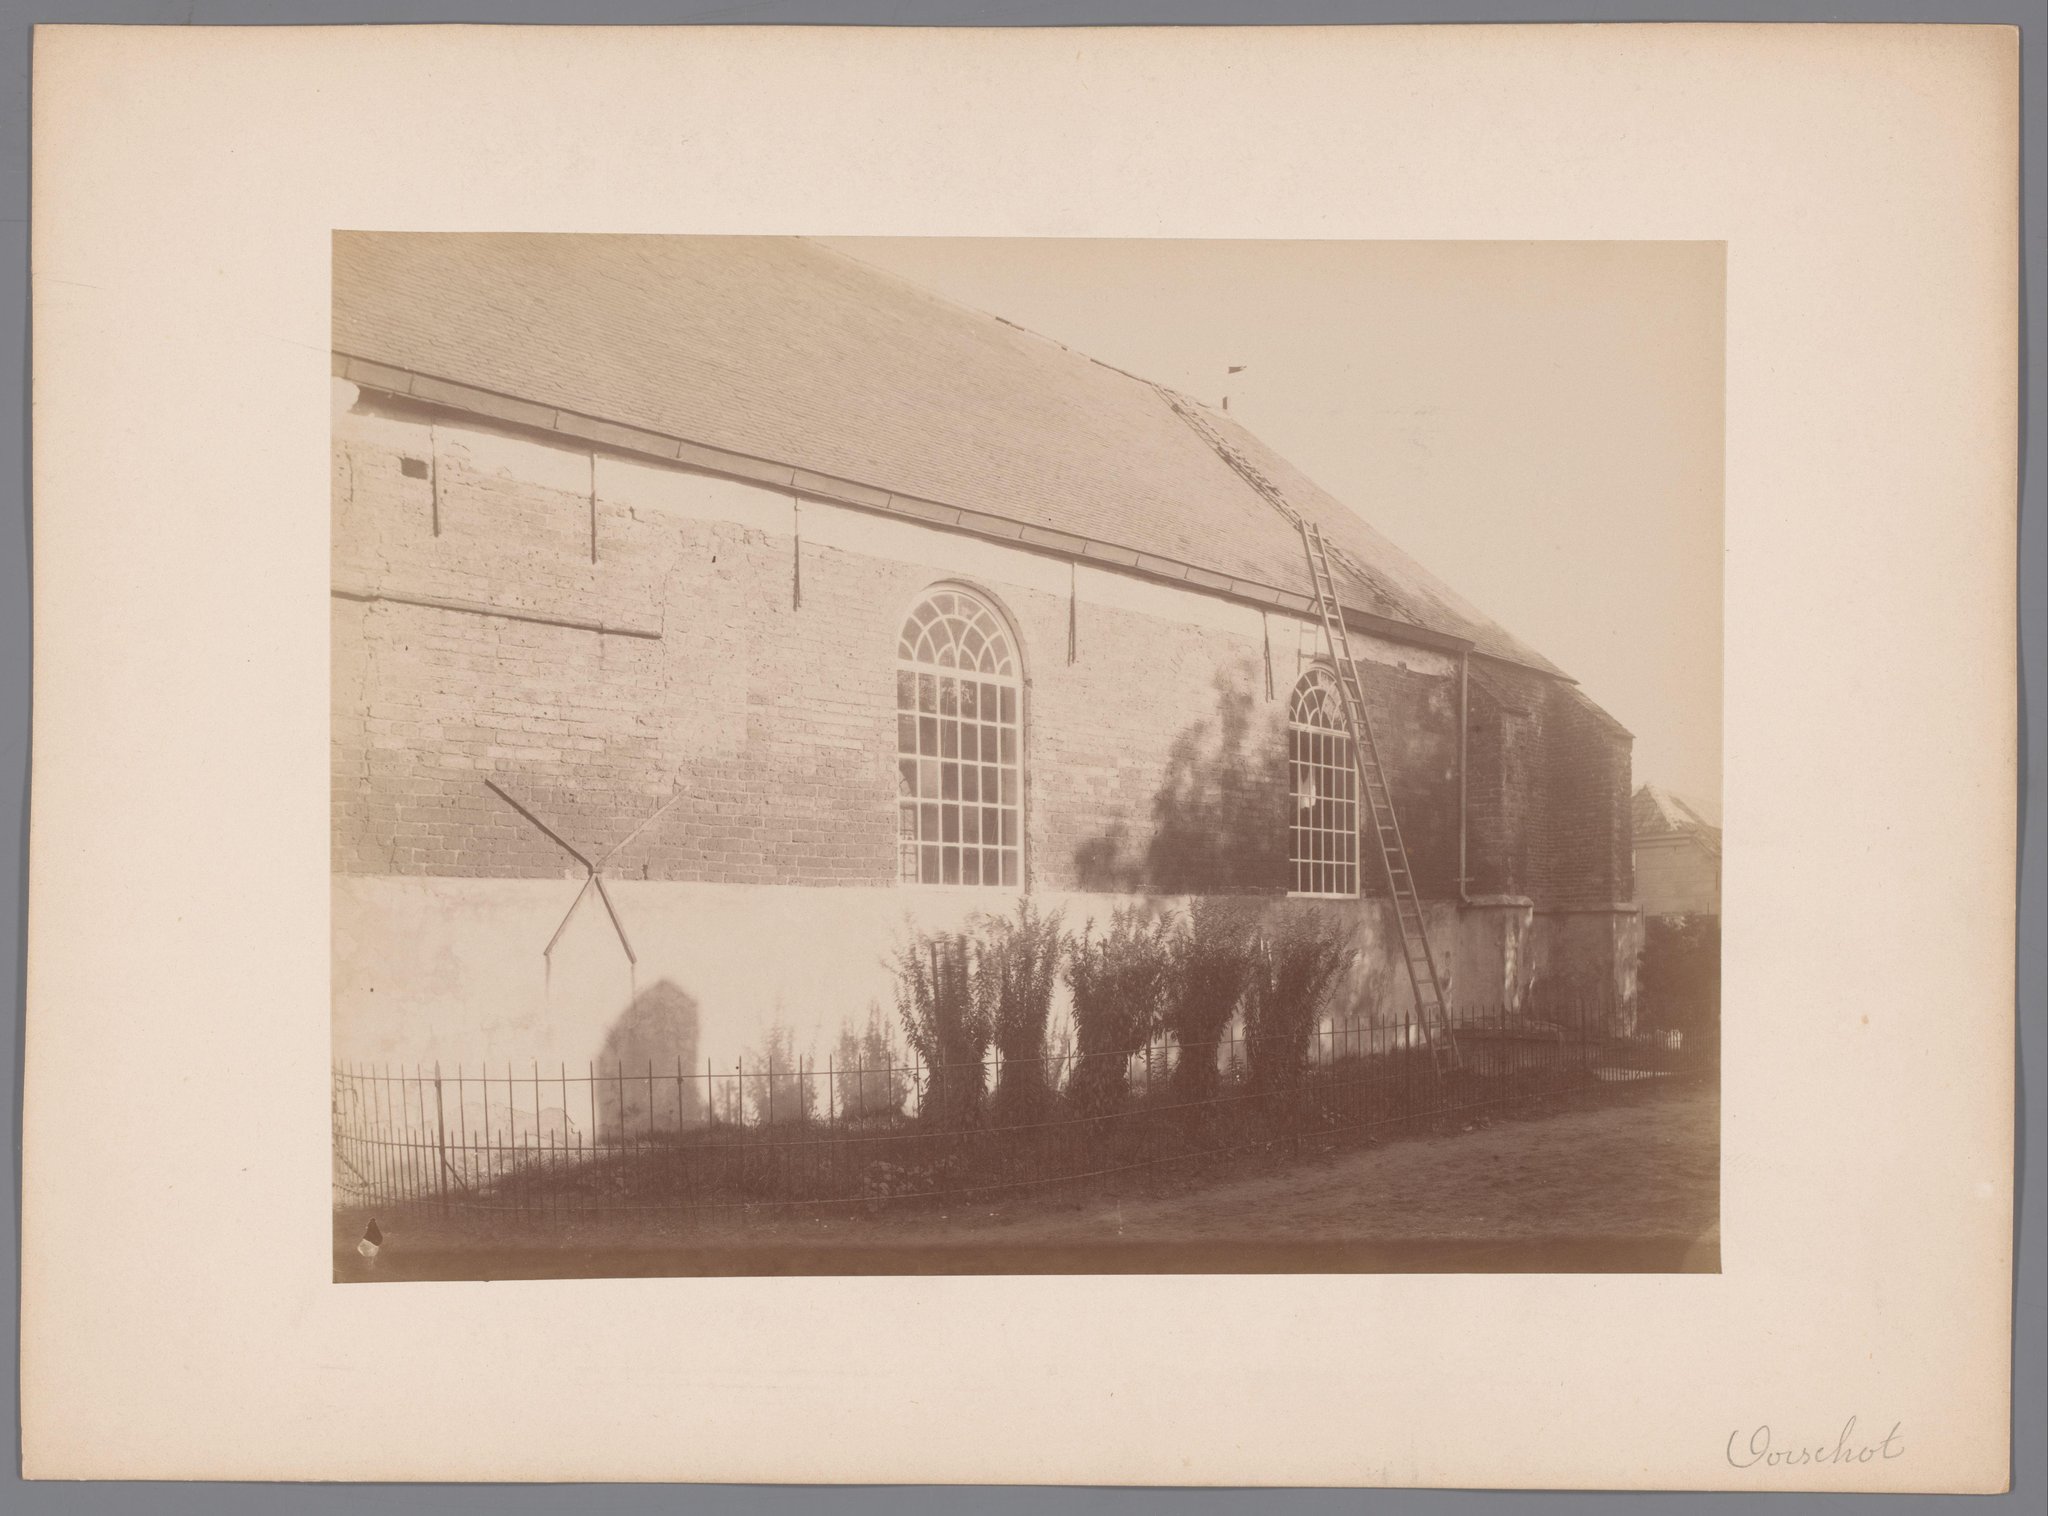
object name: photograph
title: Gedeelte van de Hervormde Kerk te Oirschot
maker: anoniem (monumentenzorg)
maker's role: fotograaf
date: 1890-1920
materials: cardboard, photographic support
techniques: albumen print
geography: oirschot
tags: church (exterior)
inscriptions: annotation: ‘Oorschot N.H. Kerk’, annotation: ‘Oorschot N.B.’